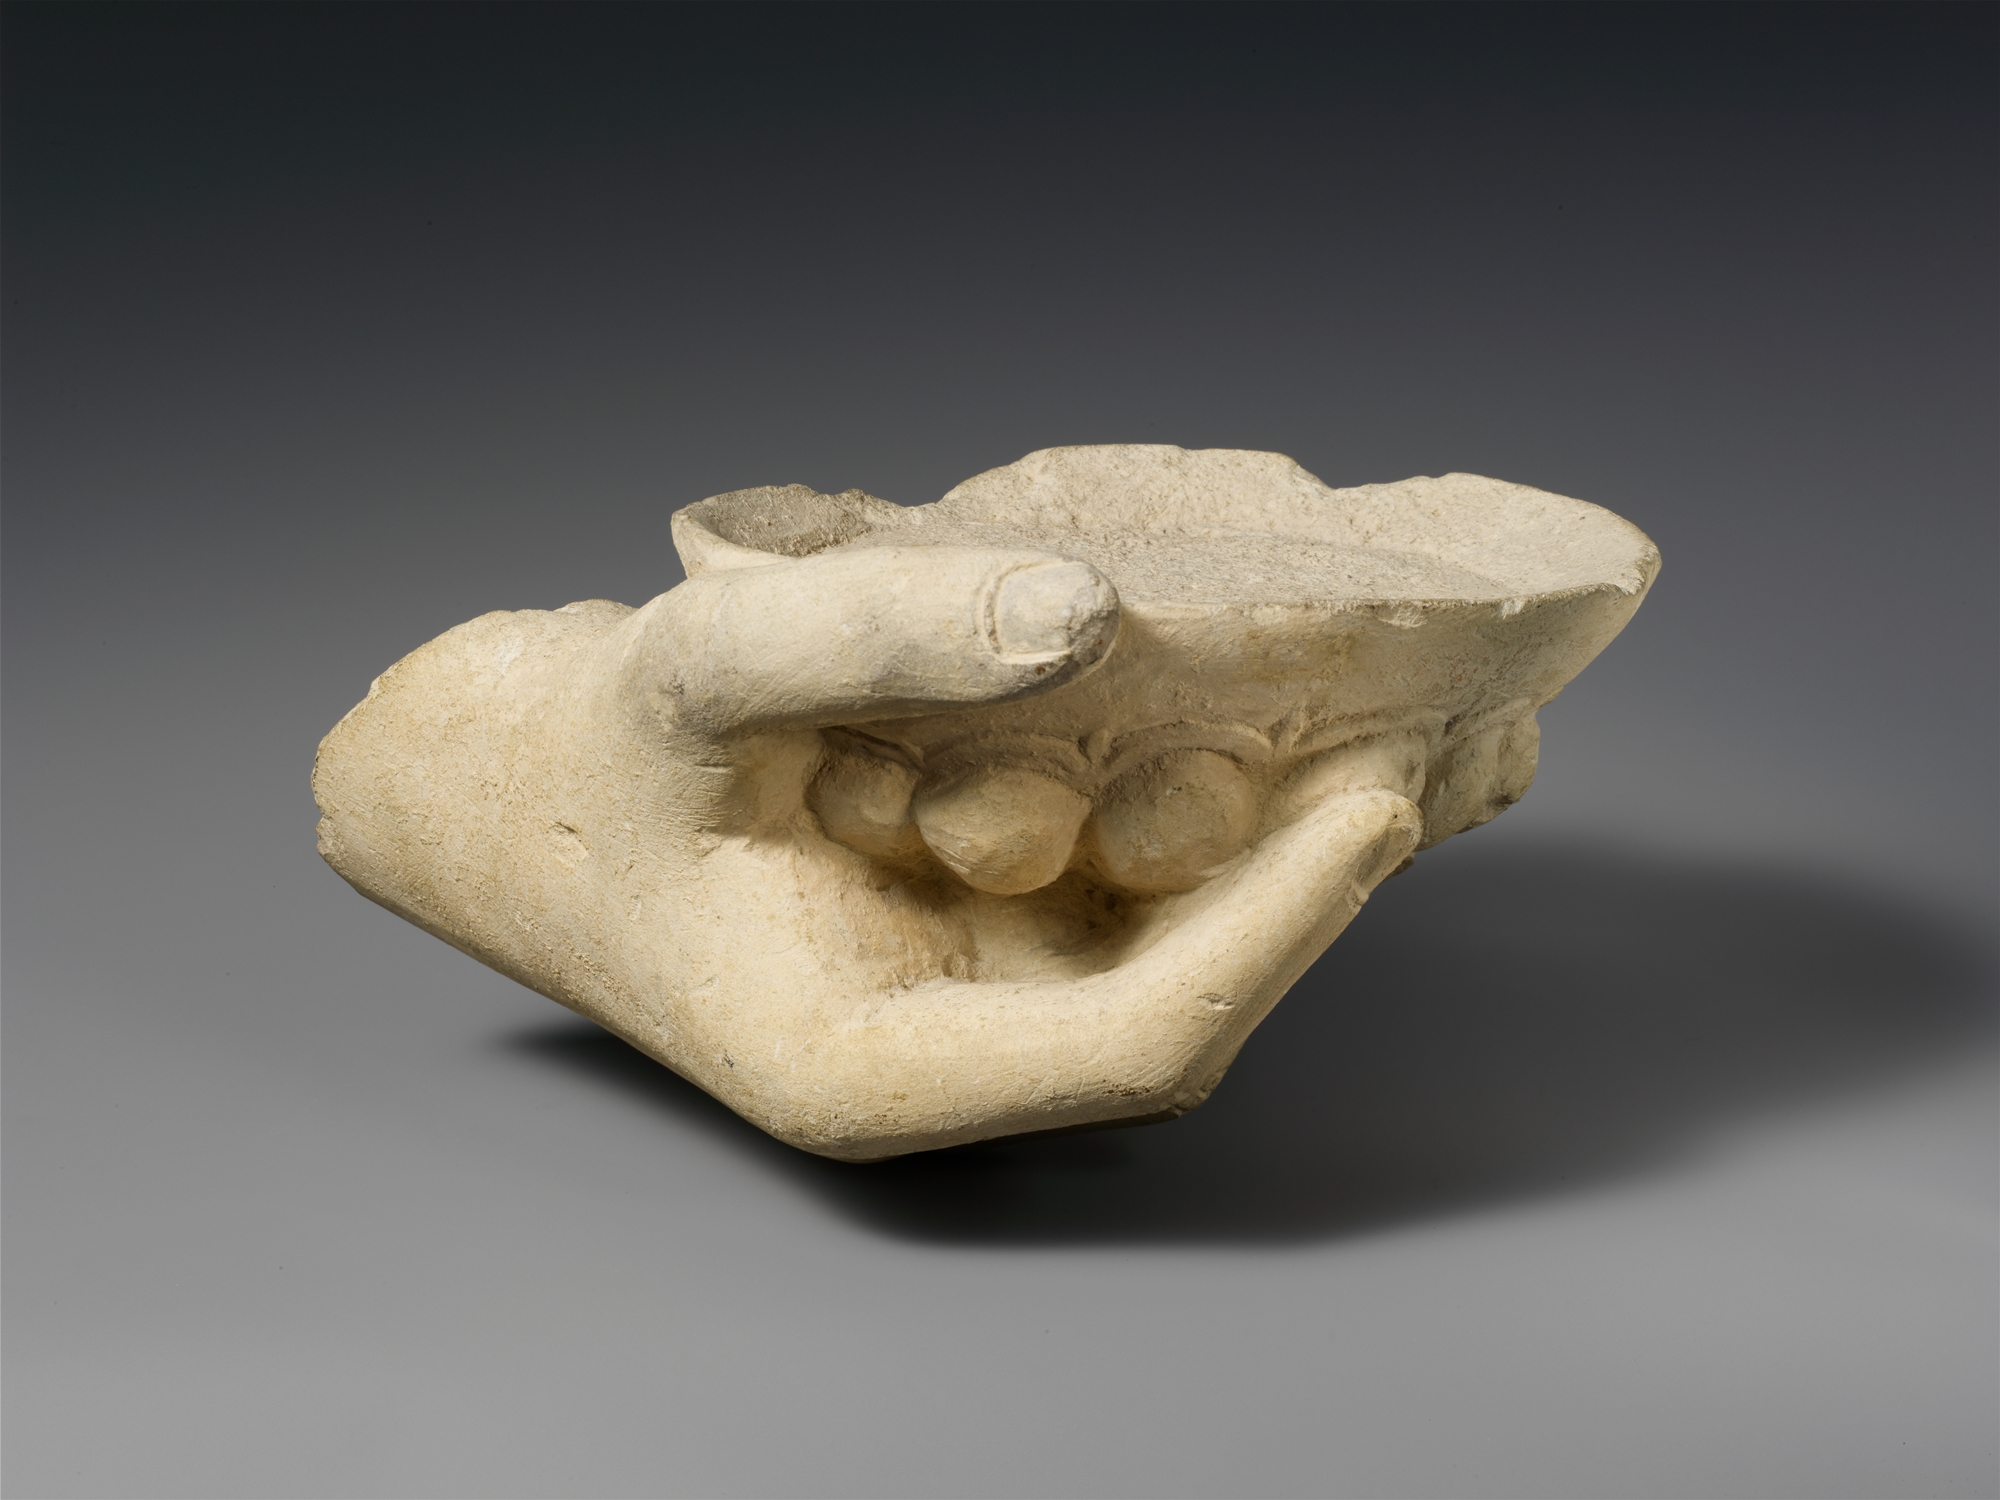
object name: statue fragment of a right hand holding a phiale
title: Limestone statue fragment of a right hand holding a phiale (libation bowl)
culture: cypriot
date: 534-401 BCE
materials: limestone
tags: hands,lotuses